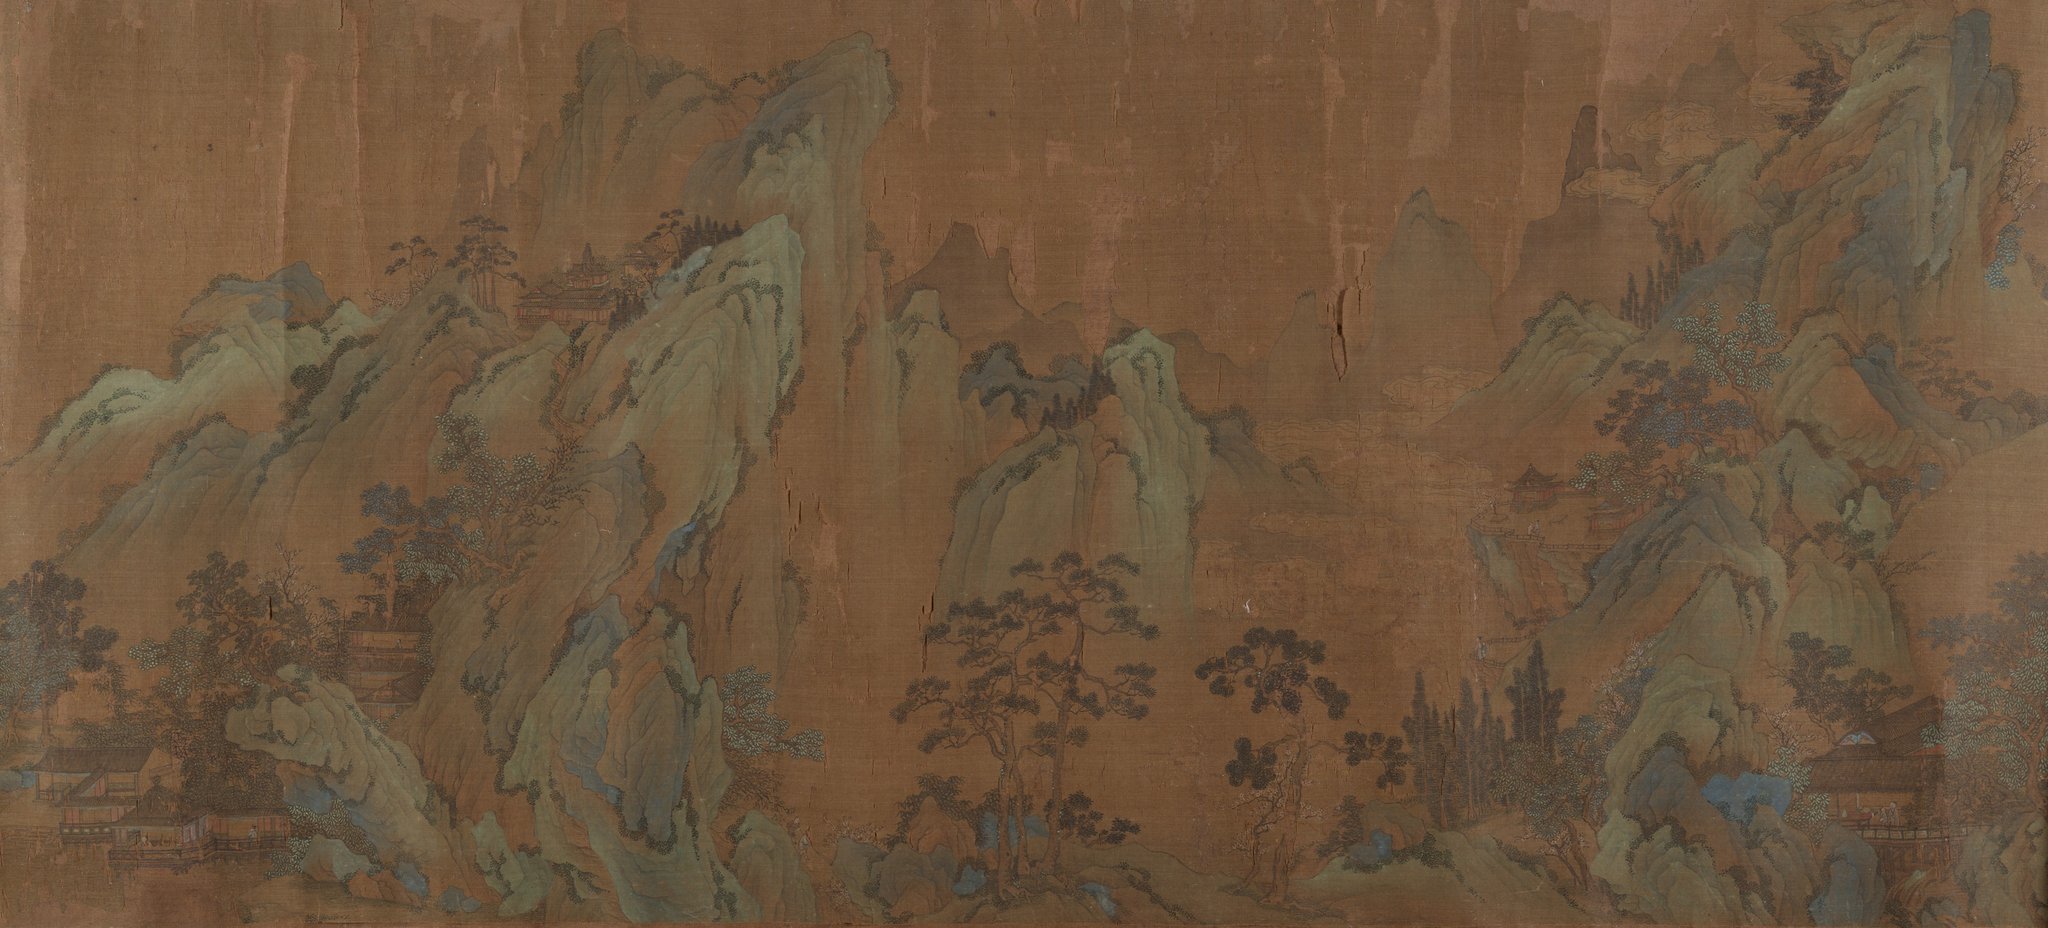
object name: handscroll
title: Landscape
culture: chinese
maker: unidentified artist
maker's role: artist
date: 1368-1644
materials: ink, silk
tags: landscapes